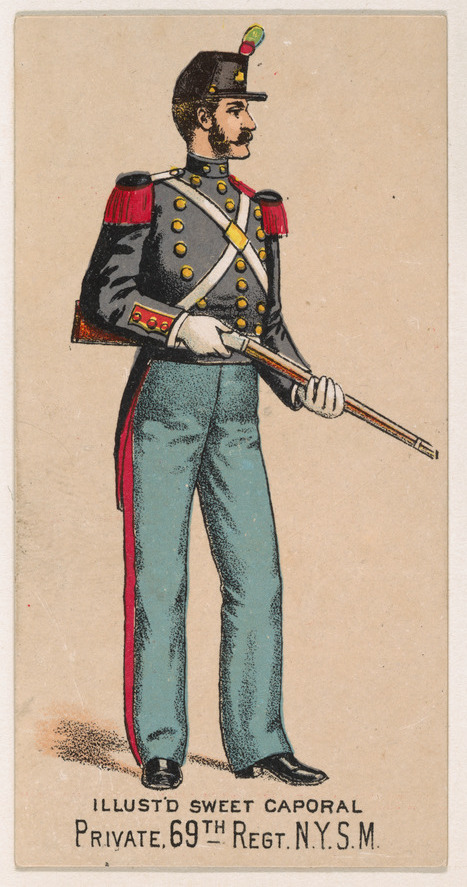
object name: print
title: Private, 69th Regiment, New York State Militia, from the Military Series (N224) issued by Kinney Tobacco Company to promote Sweet Caporal Cigarettes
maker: kinney brothers tobacco company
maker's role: publisher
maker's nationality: american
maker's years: 1869-2011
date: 1888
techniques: color lithograph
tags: soldiers,men,profiles